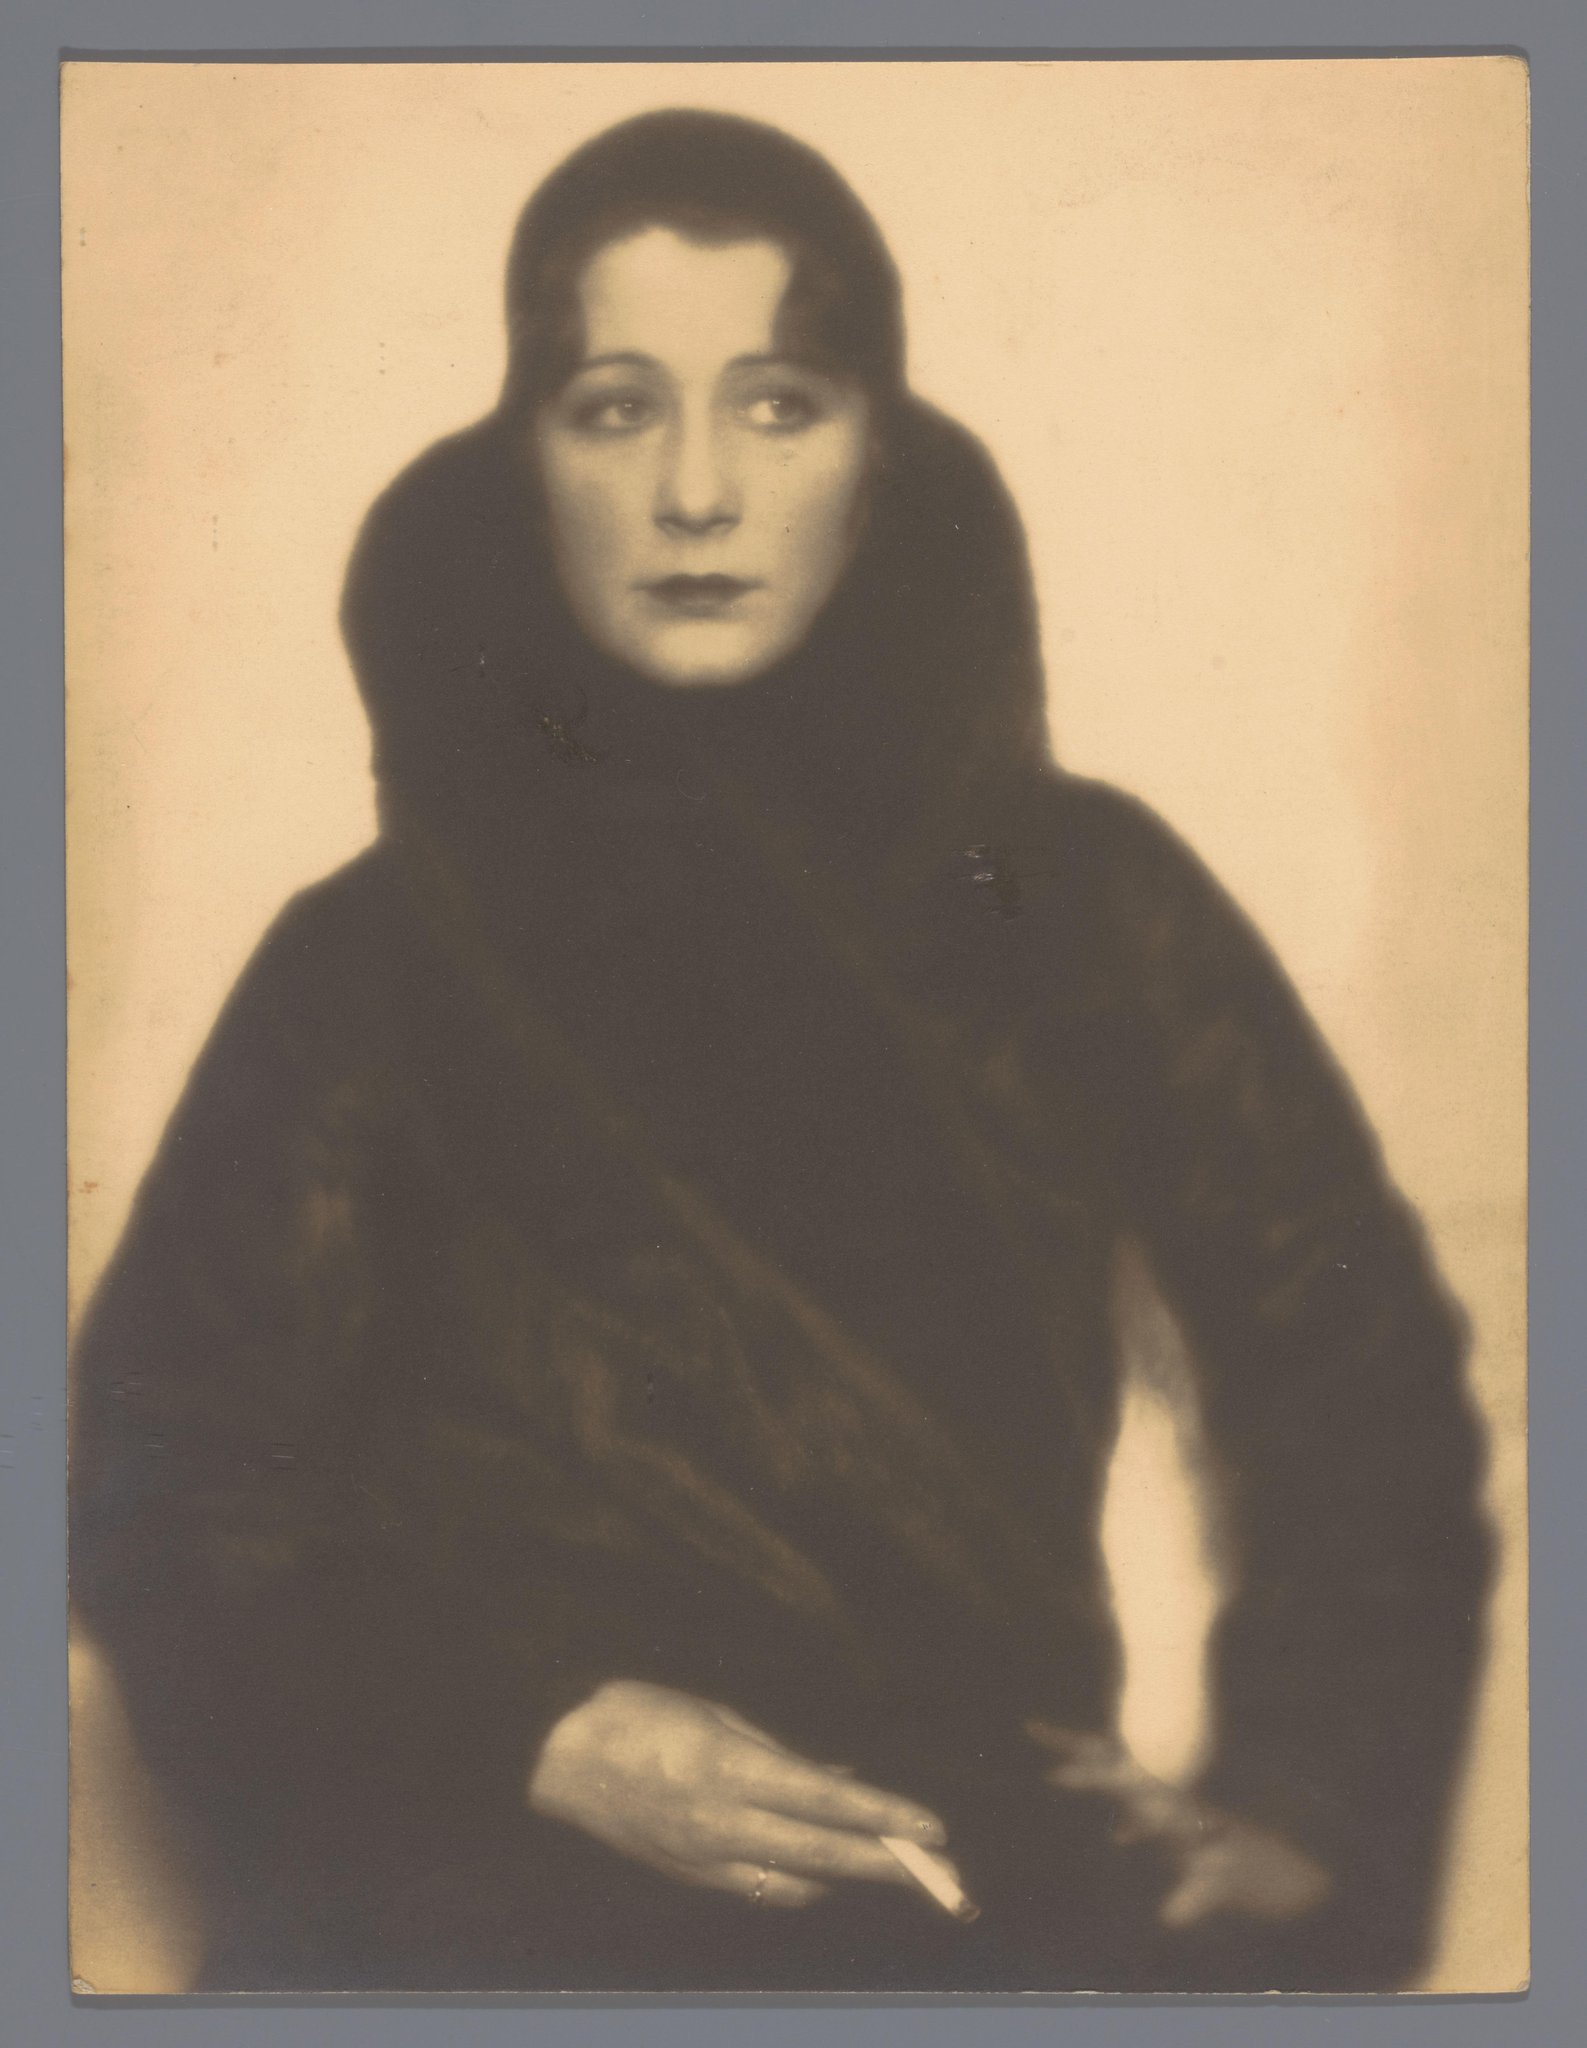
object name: photograph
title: Portret van Roly Bock, in bontjas met sigaret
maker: walther jaeger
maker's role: fotograaf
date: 1925-1940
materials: paper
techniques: gum bichromate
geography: berlin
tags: cigarette, historical persons, female singer, berlin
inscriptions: stamp: ‘Walther Jaeger/ Photographisches Atelier/ für Film, Bühne u. Presse./ Berlin SW. 11, Halleschestr. 3/ Fernspr. Bergmann 8155’, inscription: ‘Roly Bock’